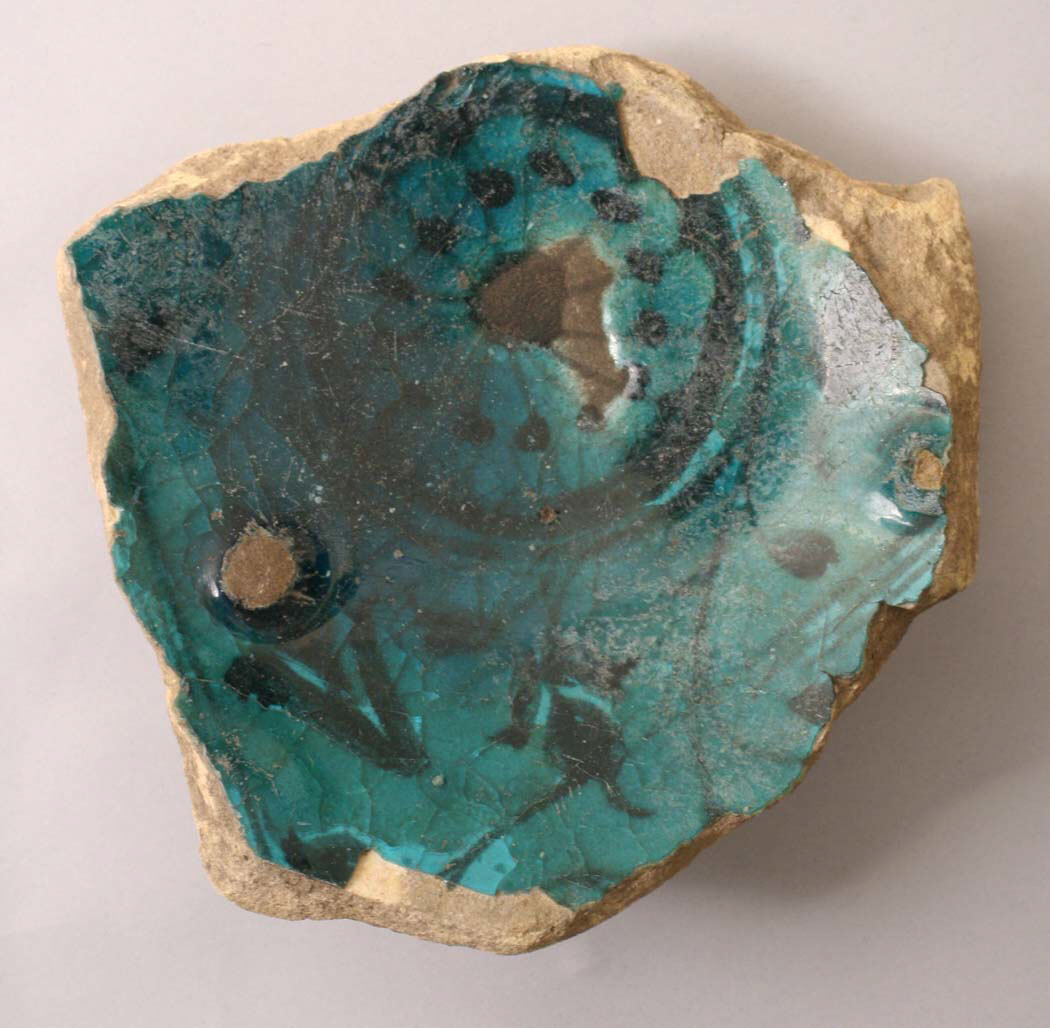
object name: ceramic fragment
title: Fragment of Bowl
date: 1301-1400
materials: glaze, stonepaste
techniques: painting, underglaze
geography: syria